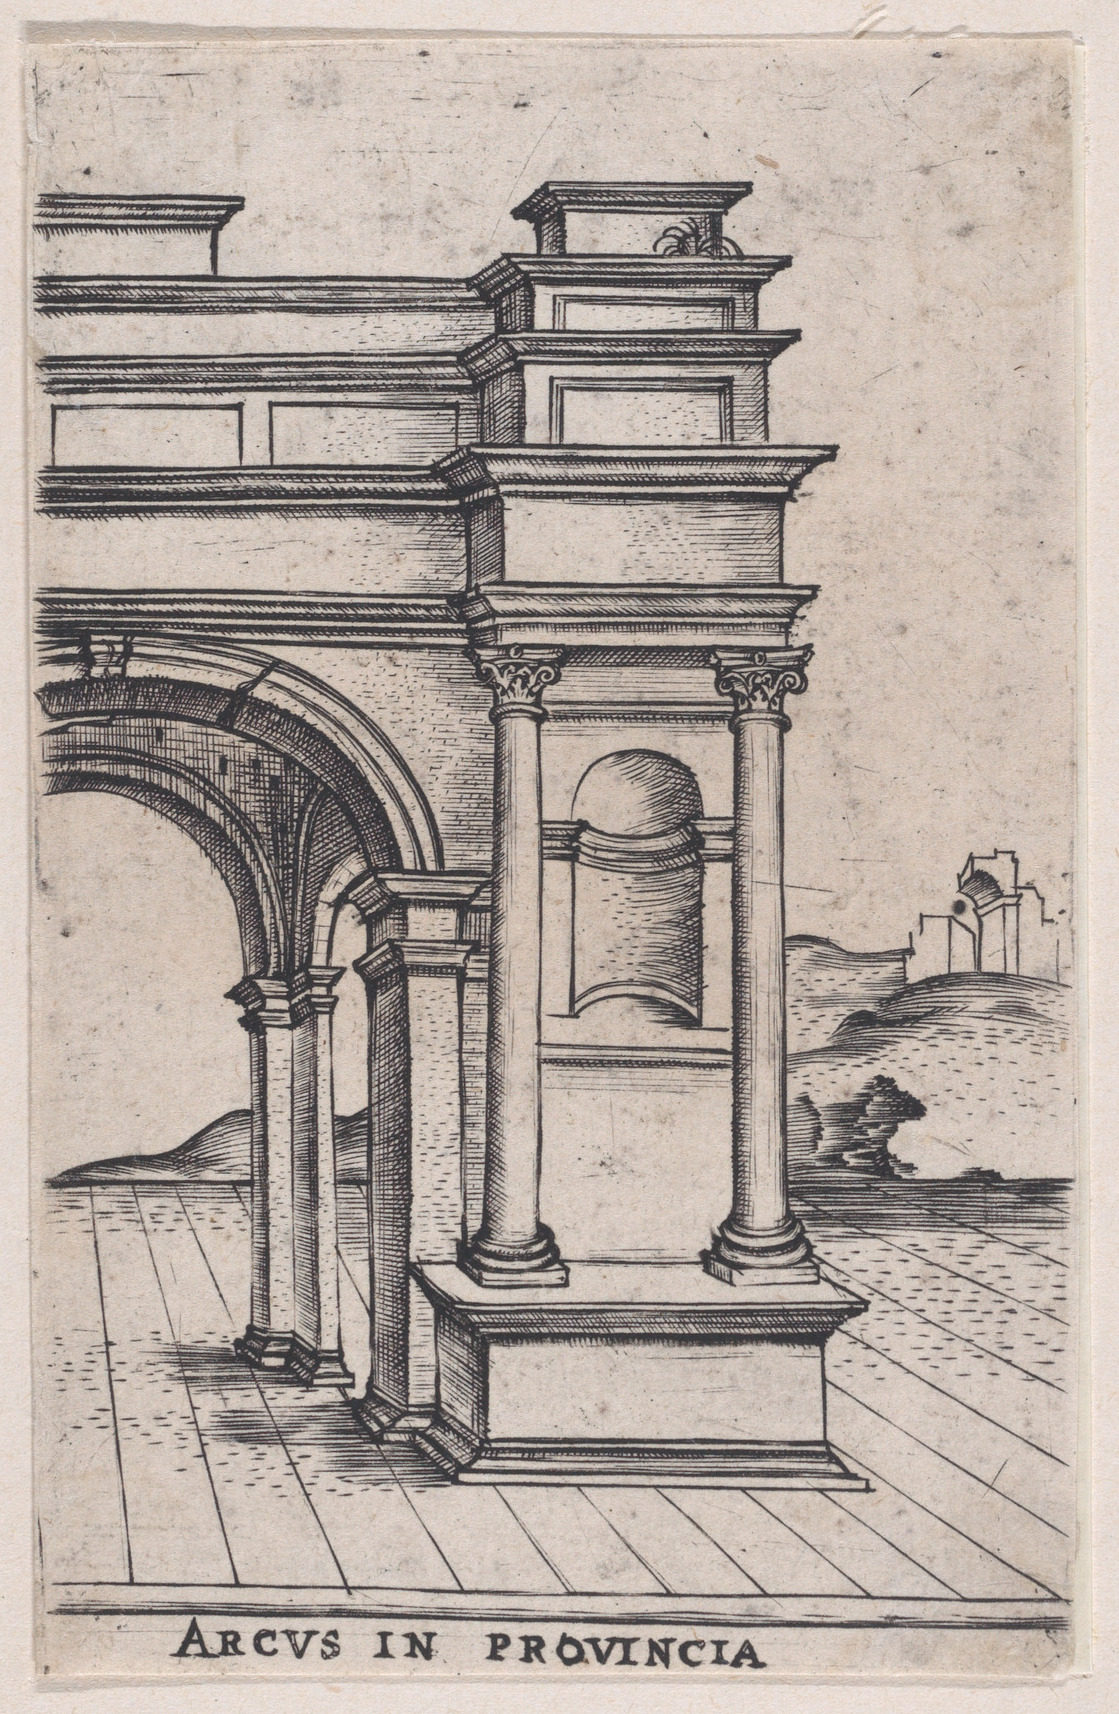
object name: print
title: Arcus in Provincia, from "Views of Ancient Roman Temples and Arches"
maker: anonymous, italian, 16th century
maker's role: artist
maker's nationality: italian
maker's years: 1500-1600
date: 1535-1540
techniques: engraving